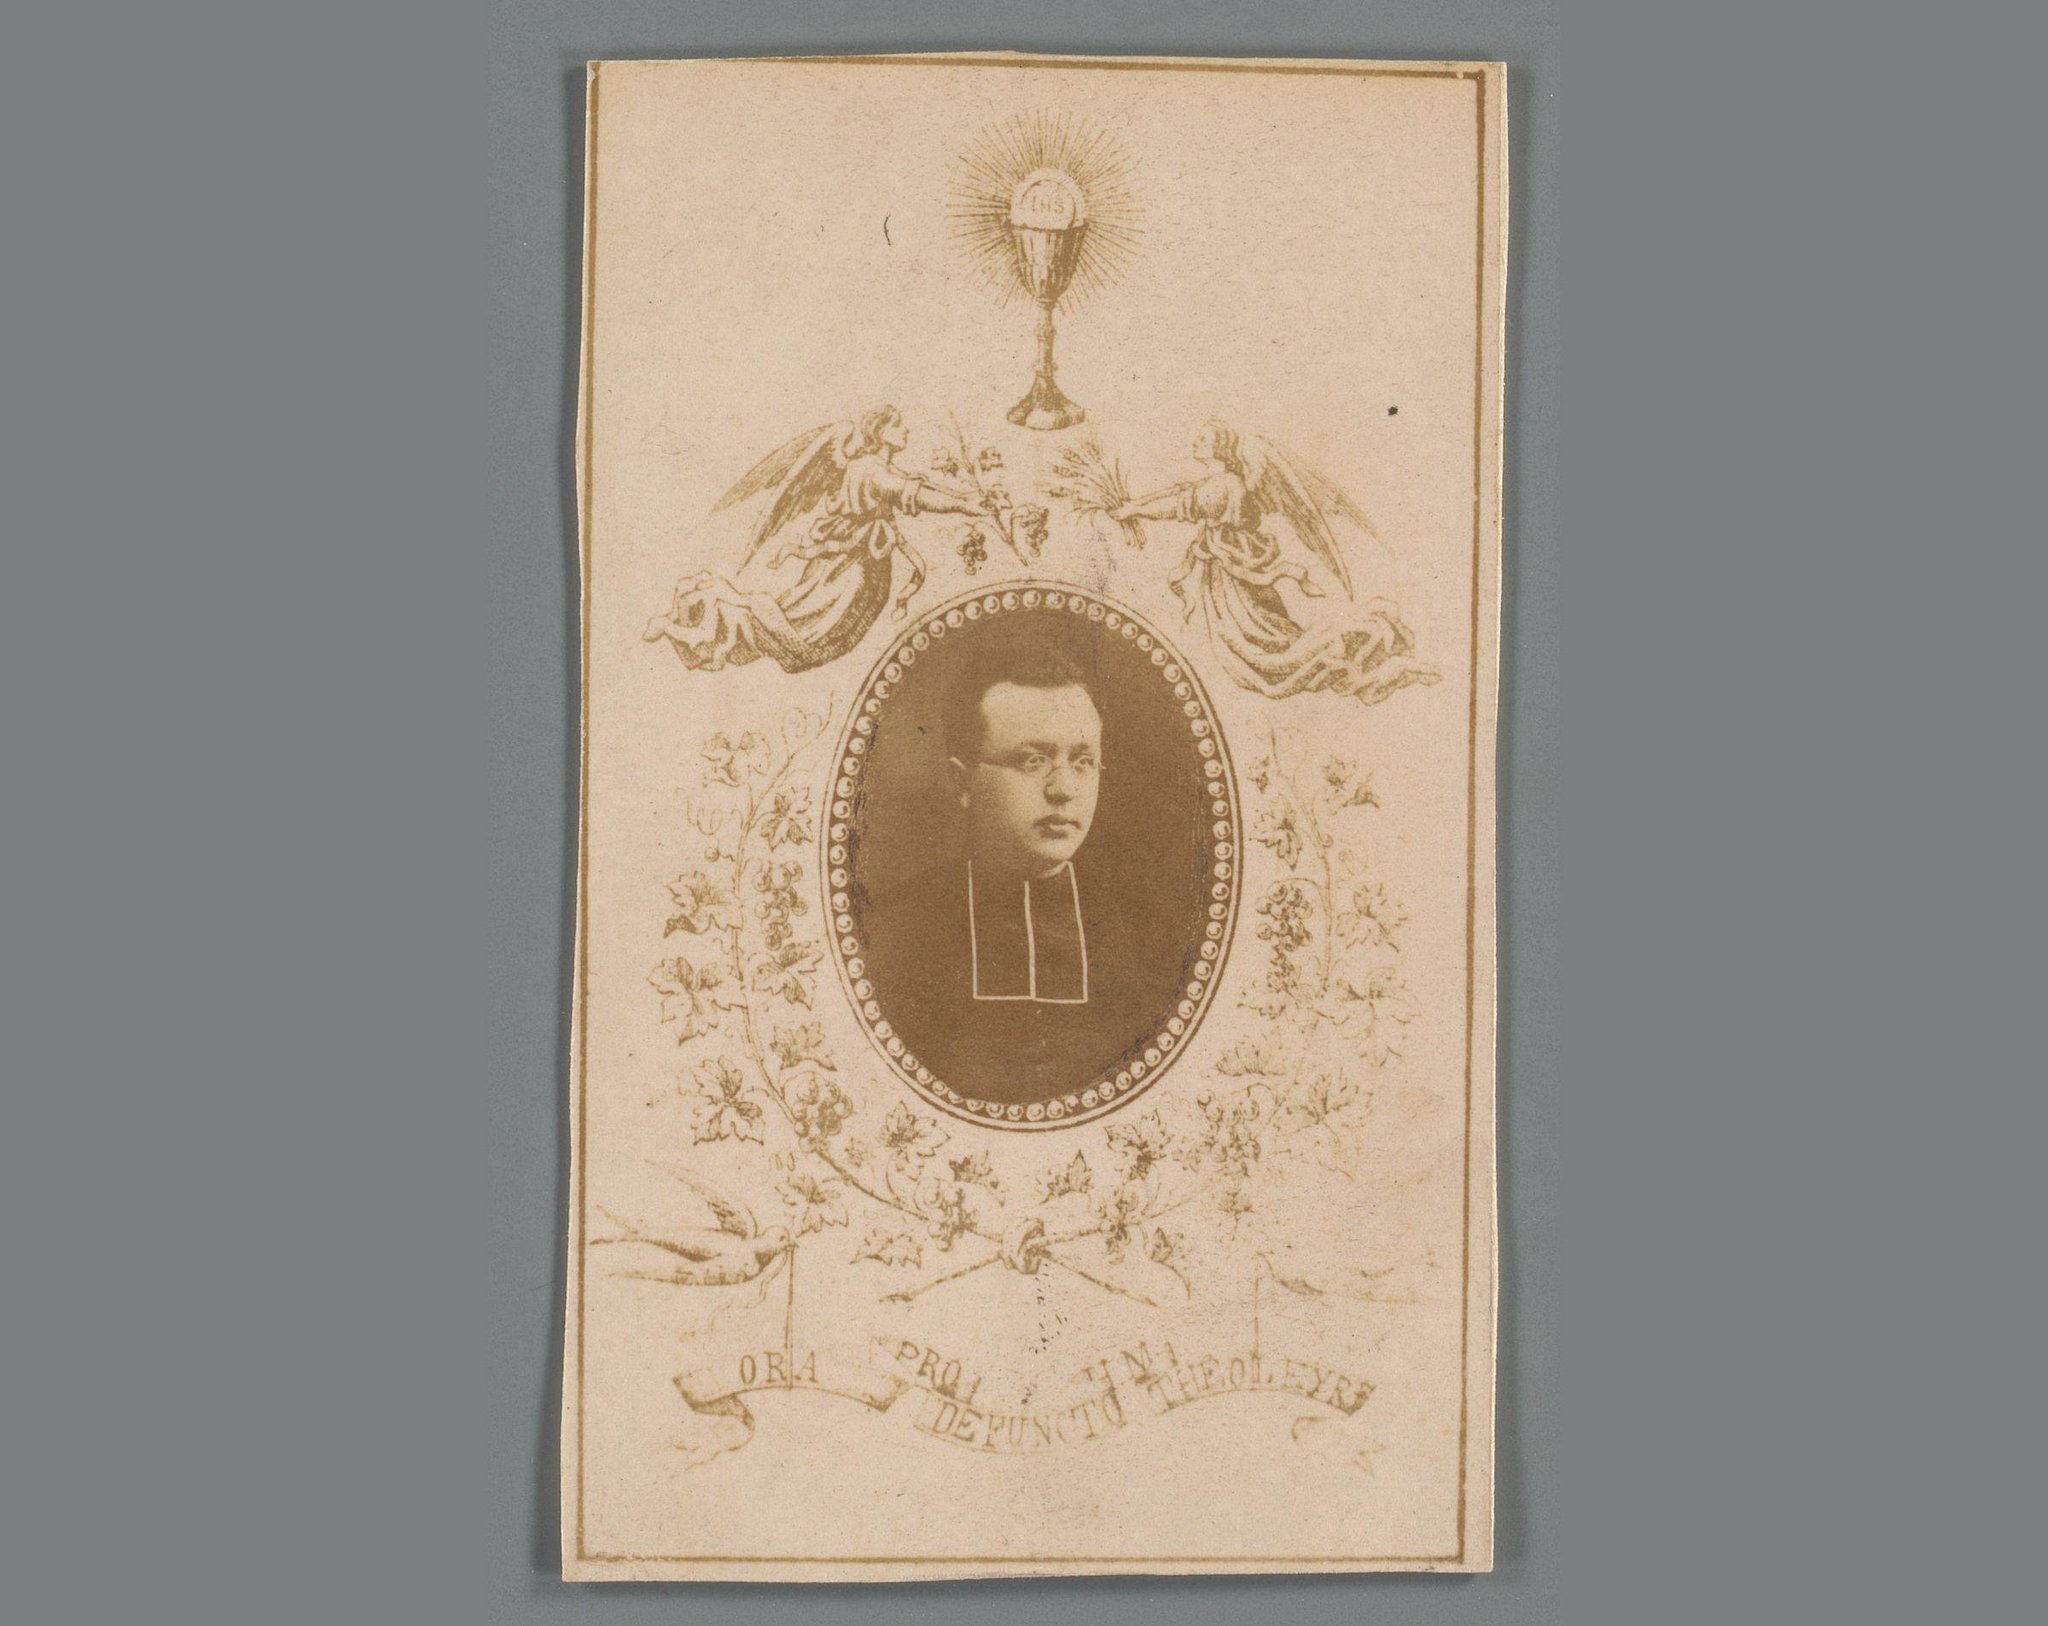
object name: reproduction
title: Portret van Hilaire Théoleyre op bidprent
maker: Anonymous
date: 1889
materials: cardboard, paper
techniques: albumen print, lithograph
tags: abbot, historical persons, angels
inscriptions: inscription: ‘Preiz pour le repos de l'âme de/ l'abbé Hilaire Mre Théolyre, (...) (7 ans et 7 quarantaines d'indulg.)’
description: Op de bidprent is centraal een medaillon afgebeeld met het portret van de overledene. Het medaillon wordt omringd door een fotoreproductie van een prent van een druivenrank. Boven het medaillon zweven twee engelen, die neerknielen onder een kelk met hostie.